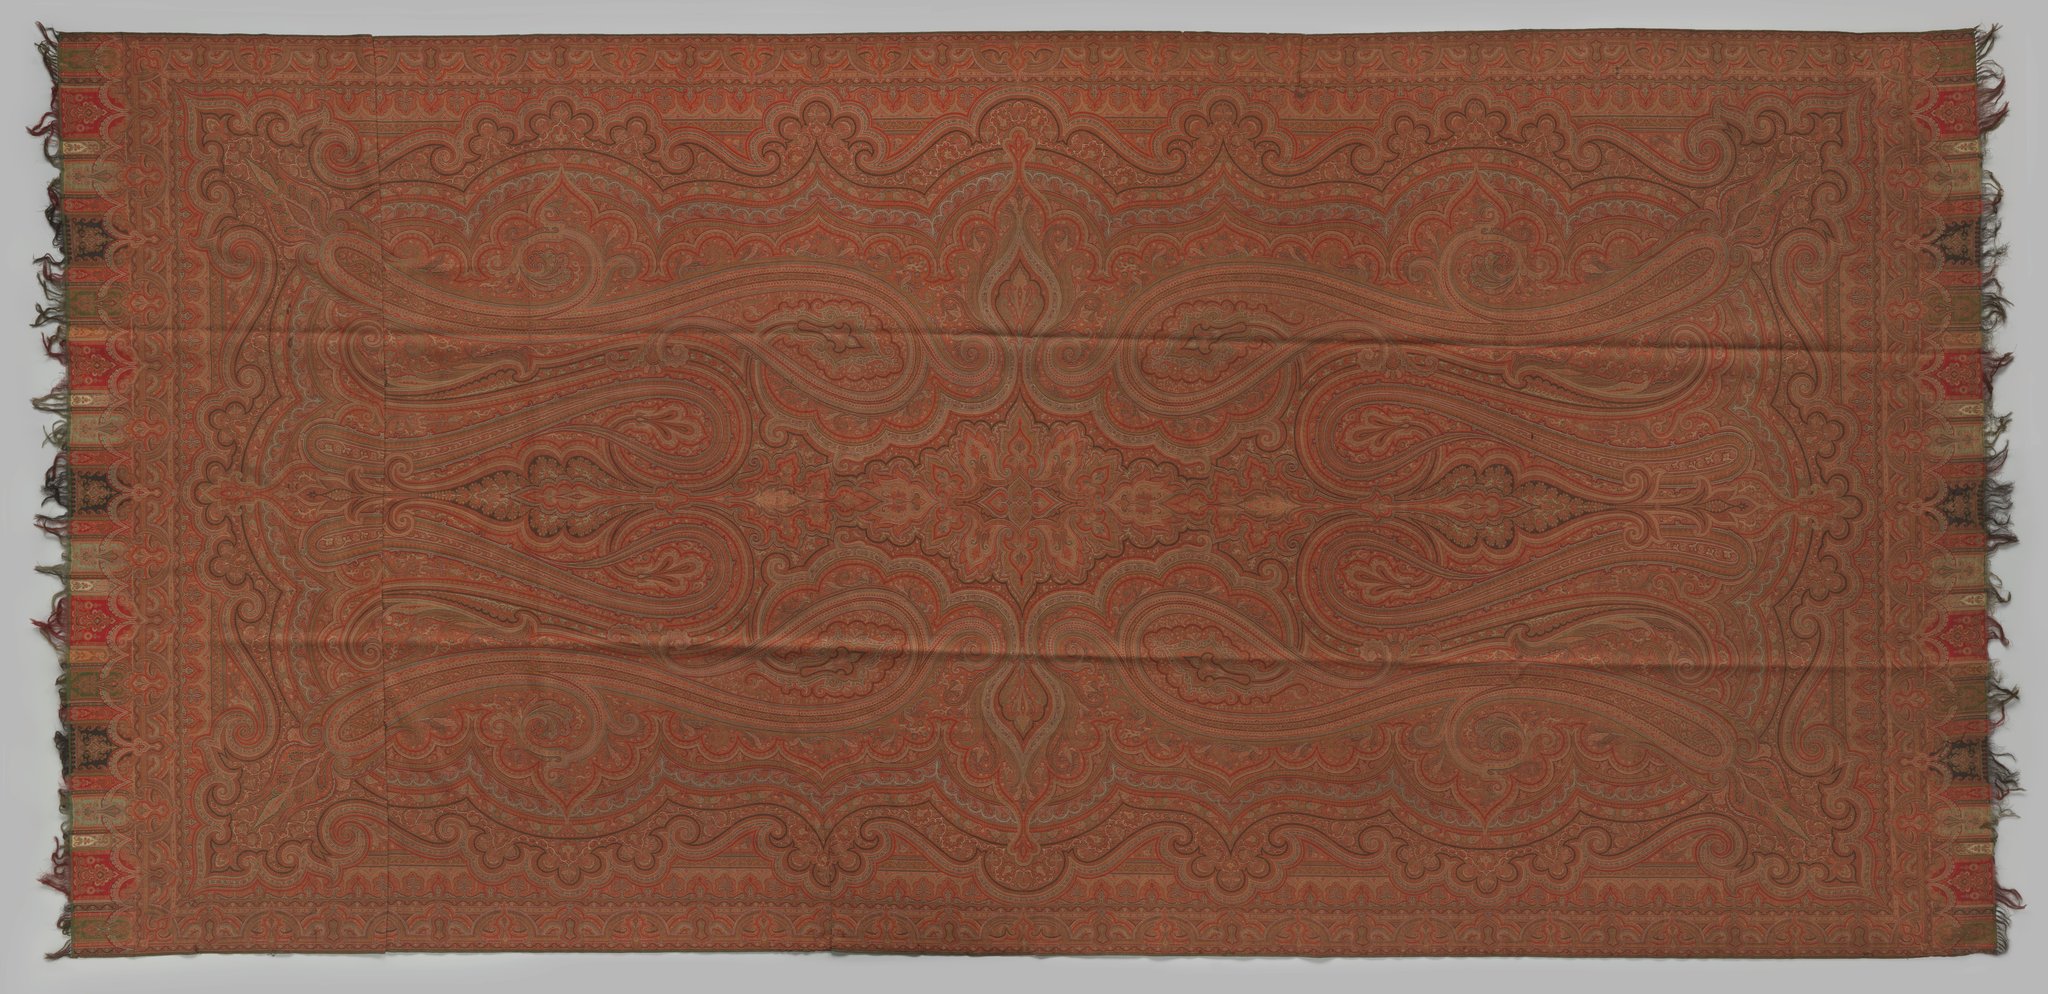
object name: kashmir shawl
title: Rechthoekige palmensjaal met een gerekte, gelobde middencartouche en een veelkleurig vol patroon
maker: Anonymous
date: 1850-1870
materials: wool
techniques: weave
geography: western europe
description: Rechthoekige palmensjaal (worteldoek) van wol, met een veelkleurig vol patroon. Het symmetrische patroon is op een lange staande en korte liggende as. In het midden een gerekte, gelobde cartouche, die wordt opgenomen in het overige decor. Aan de lange einden staan twee lange, toegewende bota's, waar, in het midden, een kleine palmet tussen hangt. OP de liggende as staat een kleine palmet, van waaruit een vierdubbele, accoladevormige zijrand loopt, doorlopend tot in de korte einden. Nrs. drie en vier hebben rozetvormige lobben, die naar buitengericht staan en in de hoek tot een palmet zijn uitgebreid. In de dubbele staande rand met naar binnen rerichte bogen en met een goede oplossing ook in de liggende randen doorlopend. In de liggende rand staan buiten de genoemde bogen poorten met effen partijen. Deze hebben van 't midden uit de kleuren van zwart, turquoise, rood, groen, waartussen smalle 'stegen' voorkomen in rood, wit, okergeel, welke zich daarna herhalen. De wollen, partieel gekleurde ketting heeft vanachter flottante inslagdraden.